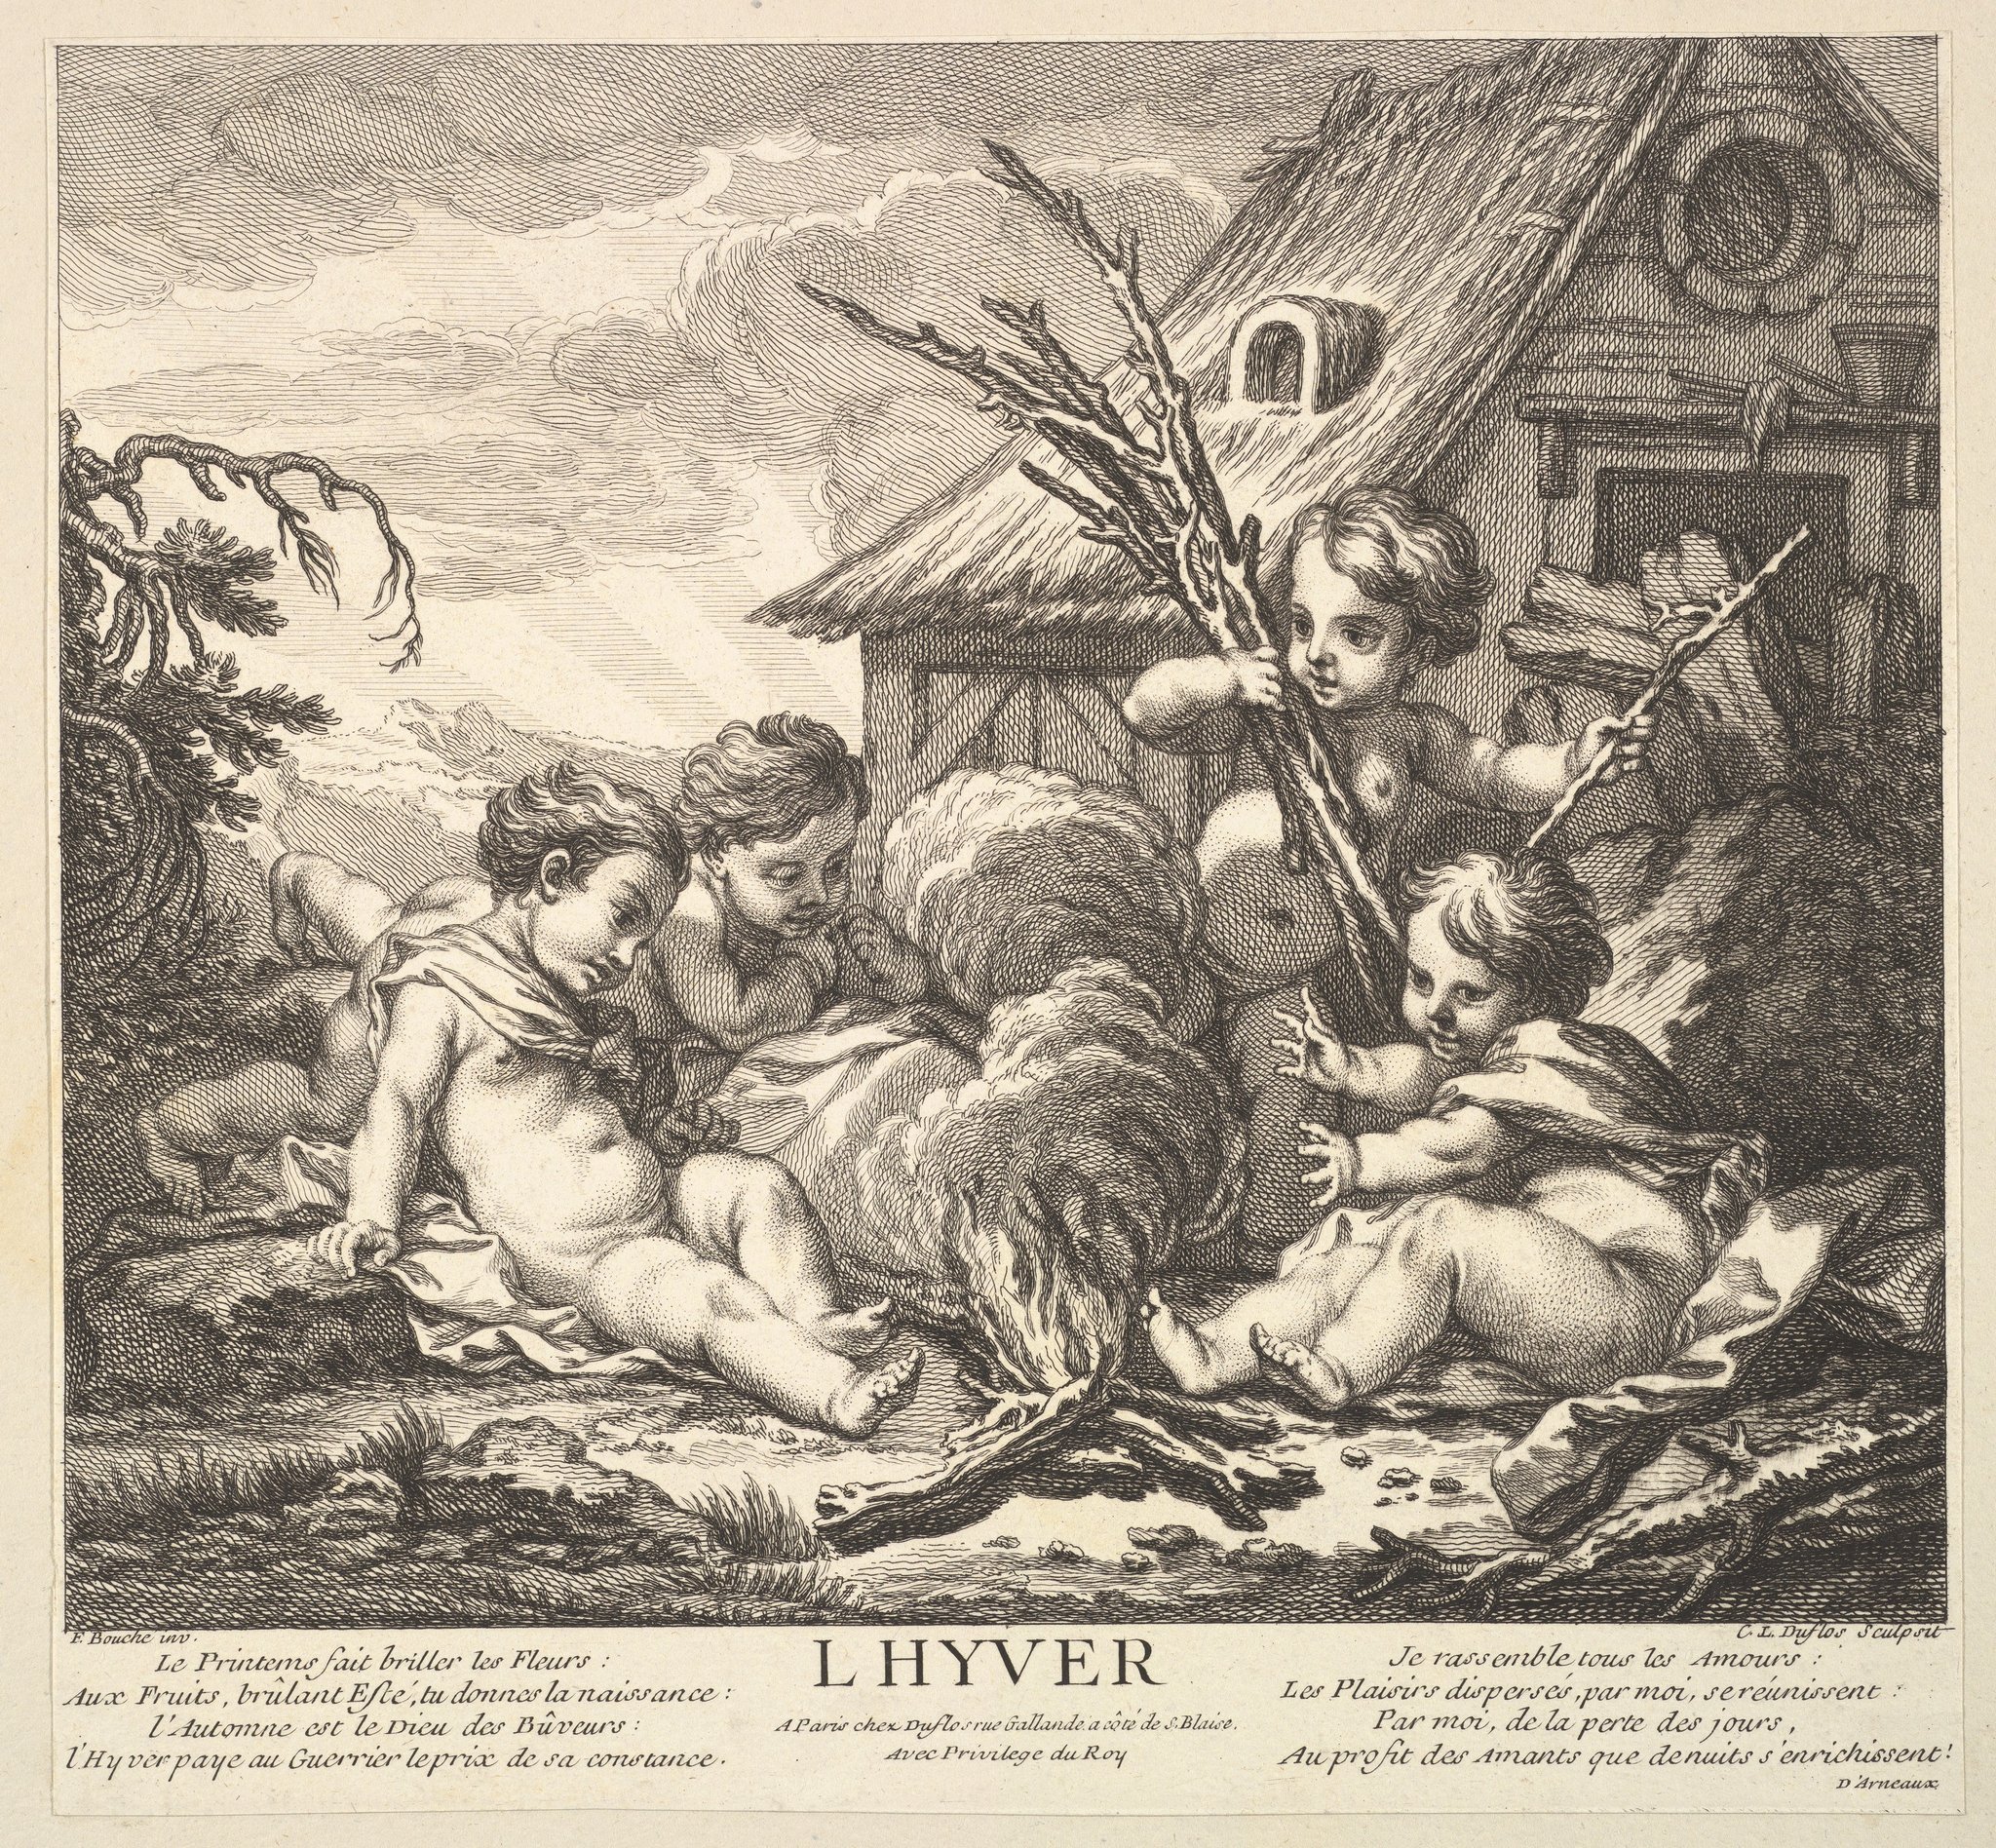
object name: print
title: Winter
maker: claude augustin duflos le jeune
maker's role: artist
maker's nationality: french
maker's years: 1700-1786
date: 1735-1786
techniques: engraving, etching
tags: children,fire,winter